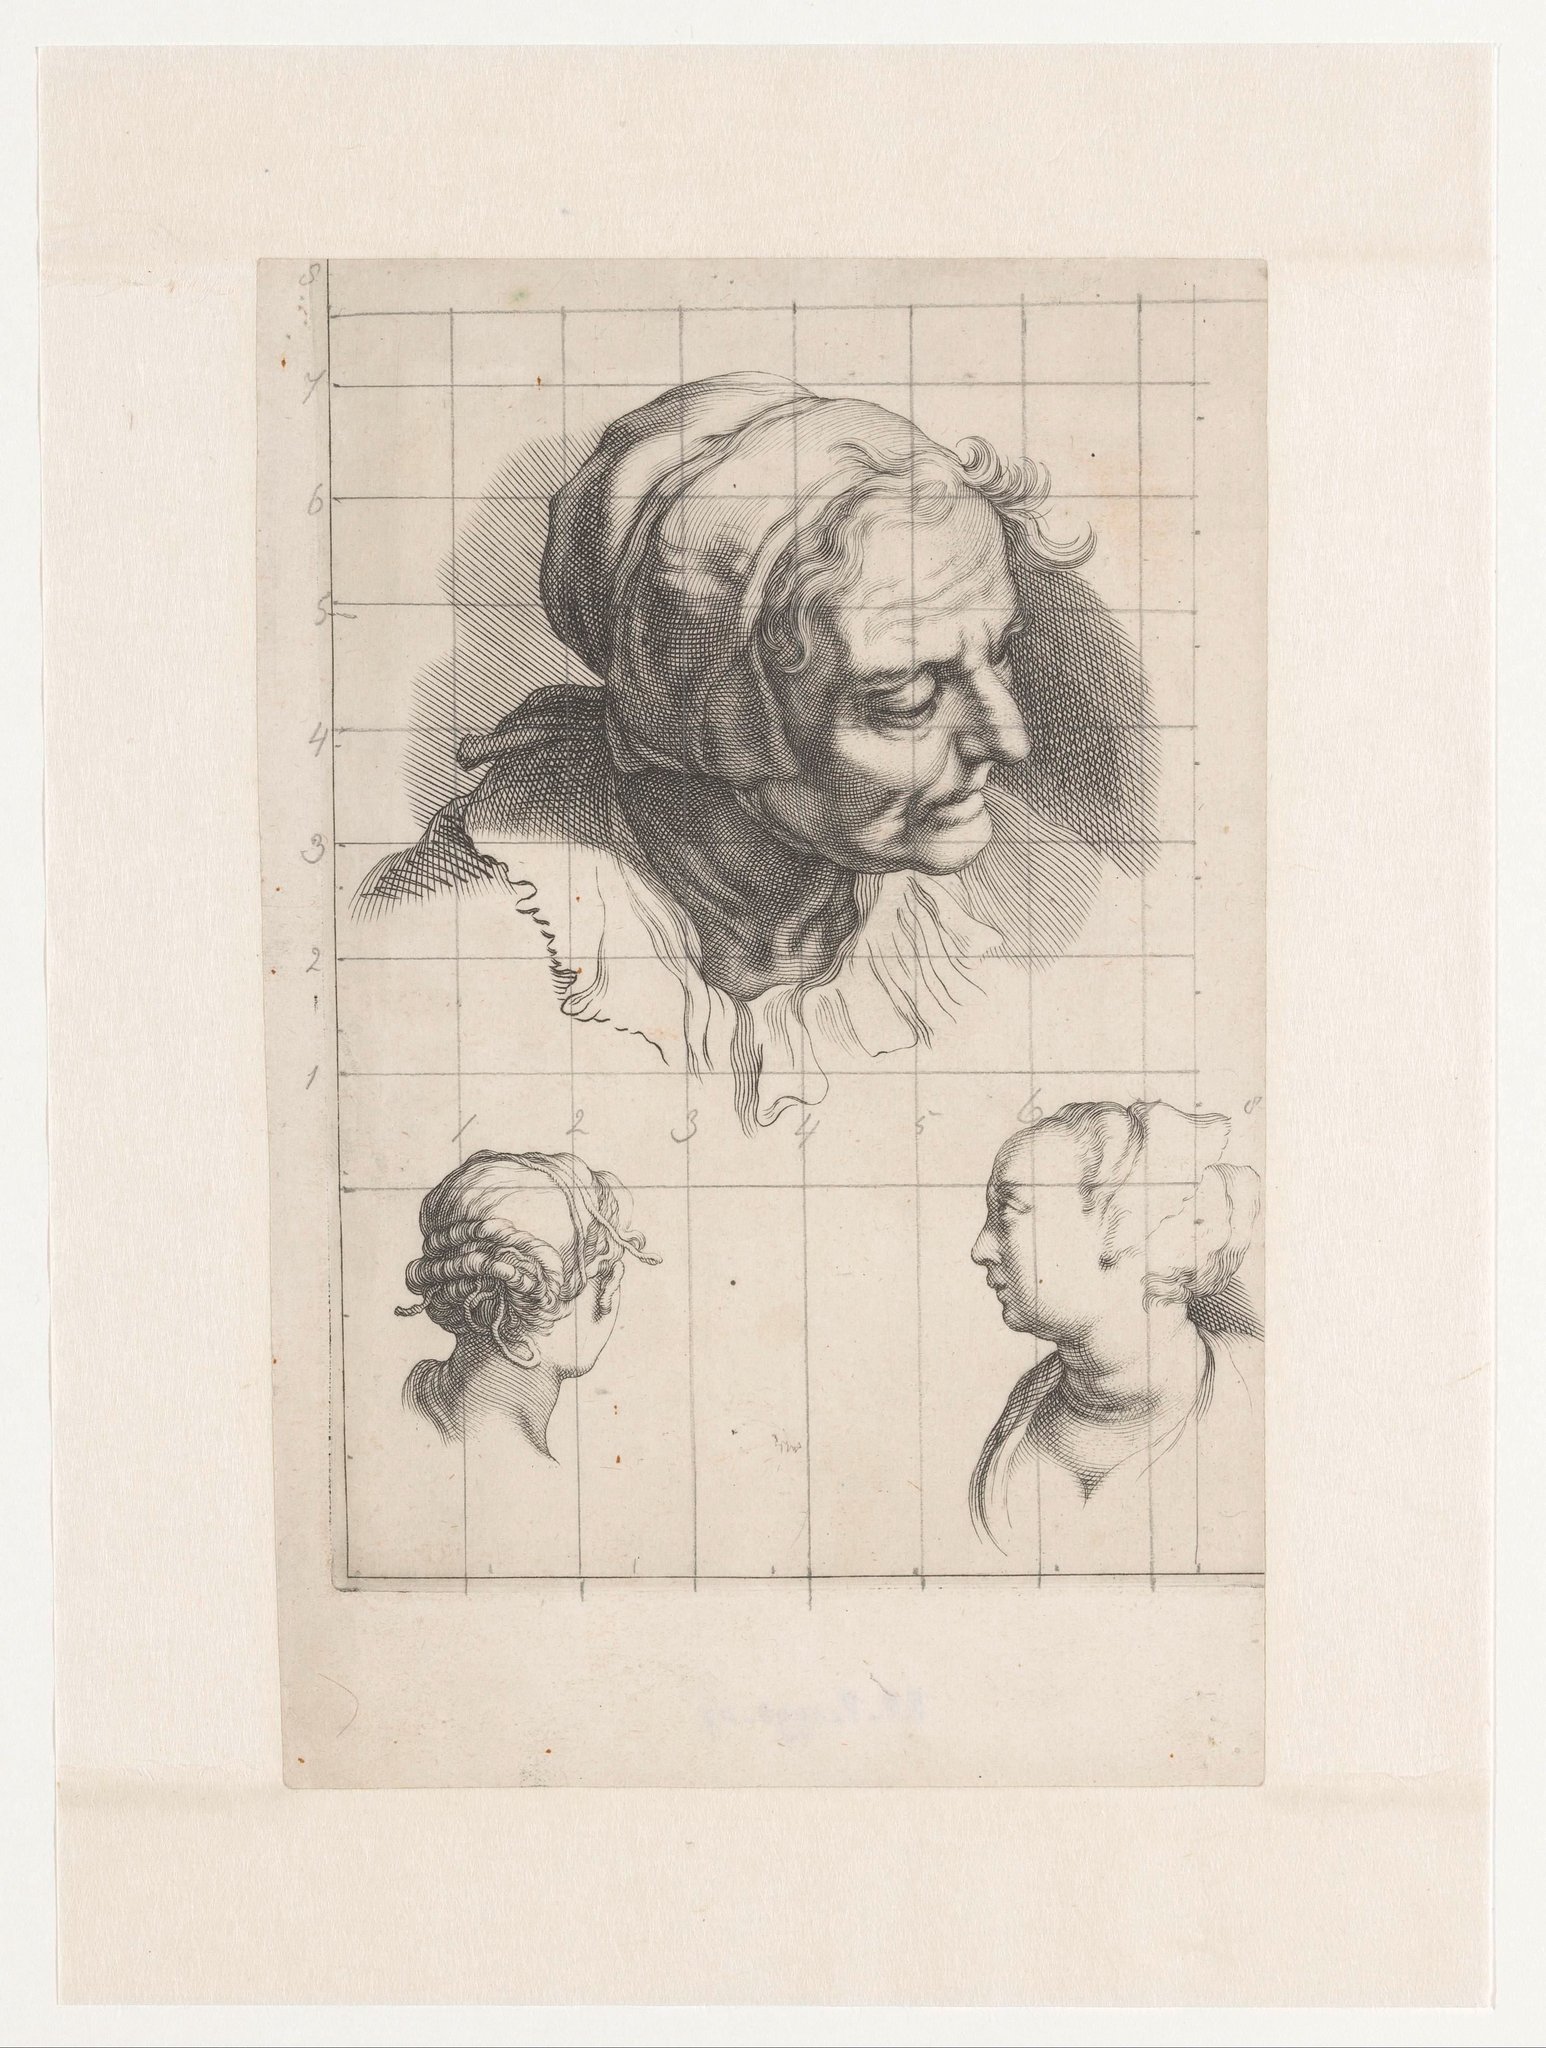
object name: print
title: Vrouwenhoofden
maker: Anonymous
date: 1650-1750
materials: paper, pencil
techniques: engraving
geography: netherlands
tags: drawing, sketch, head (human)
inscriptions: : ‘.’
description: Studies van hoofden van drie vrouwen, met rasterlijnen.